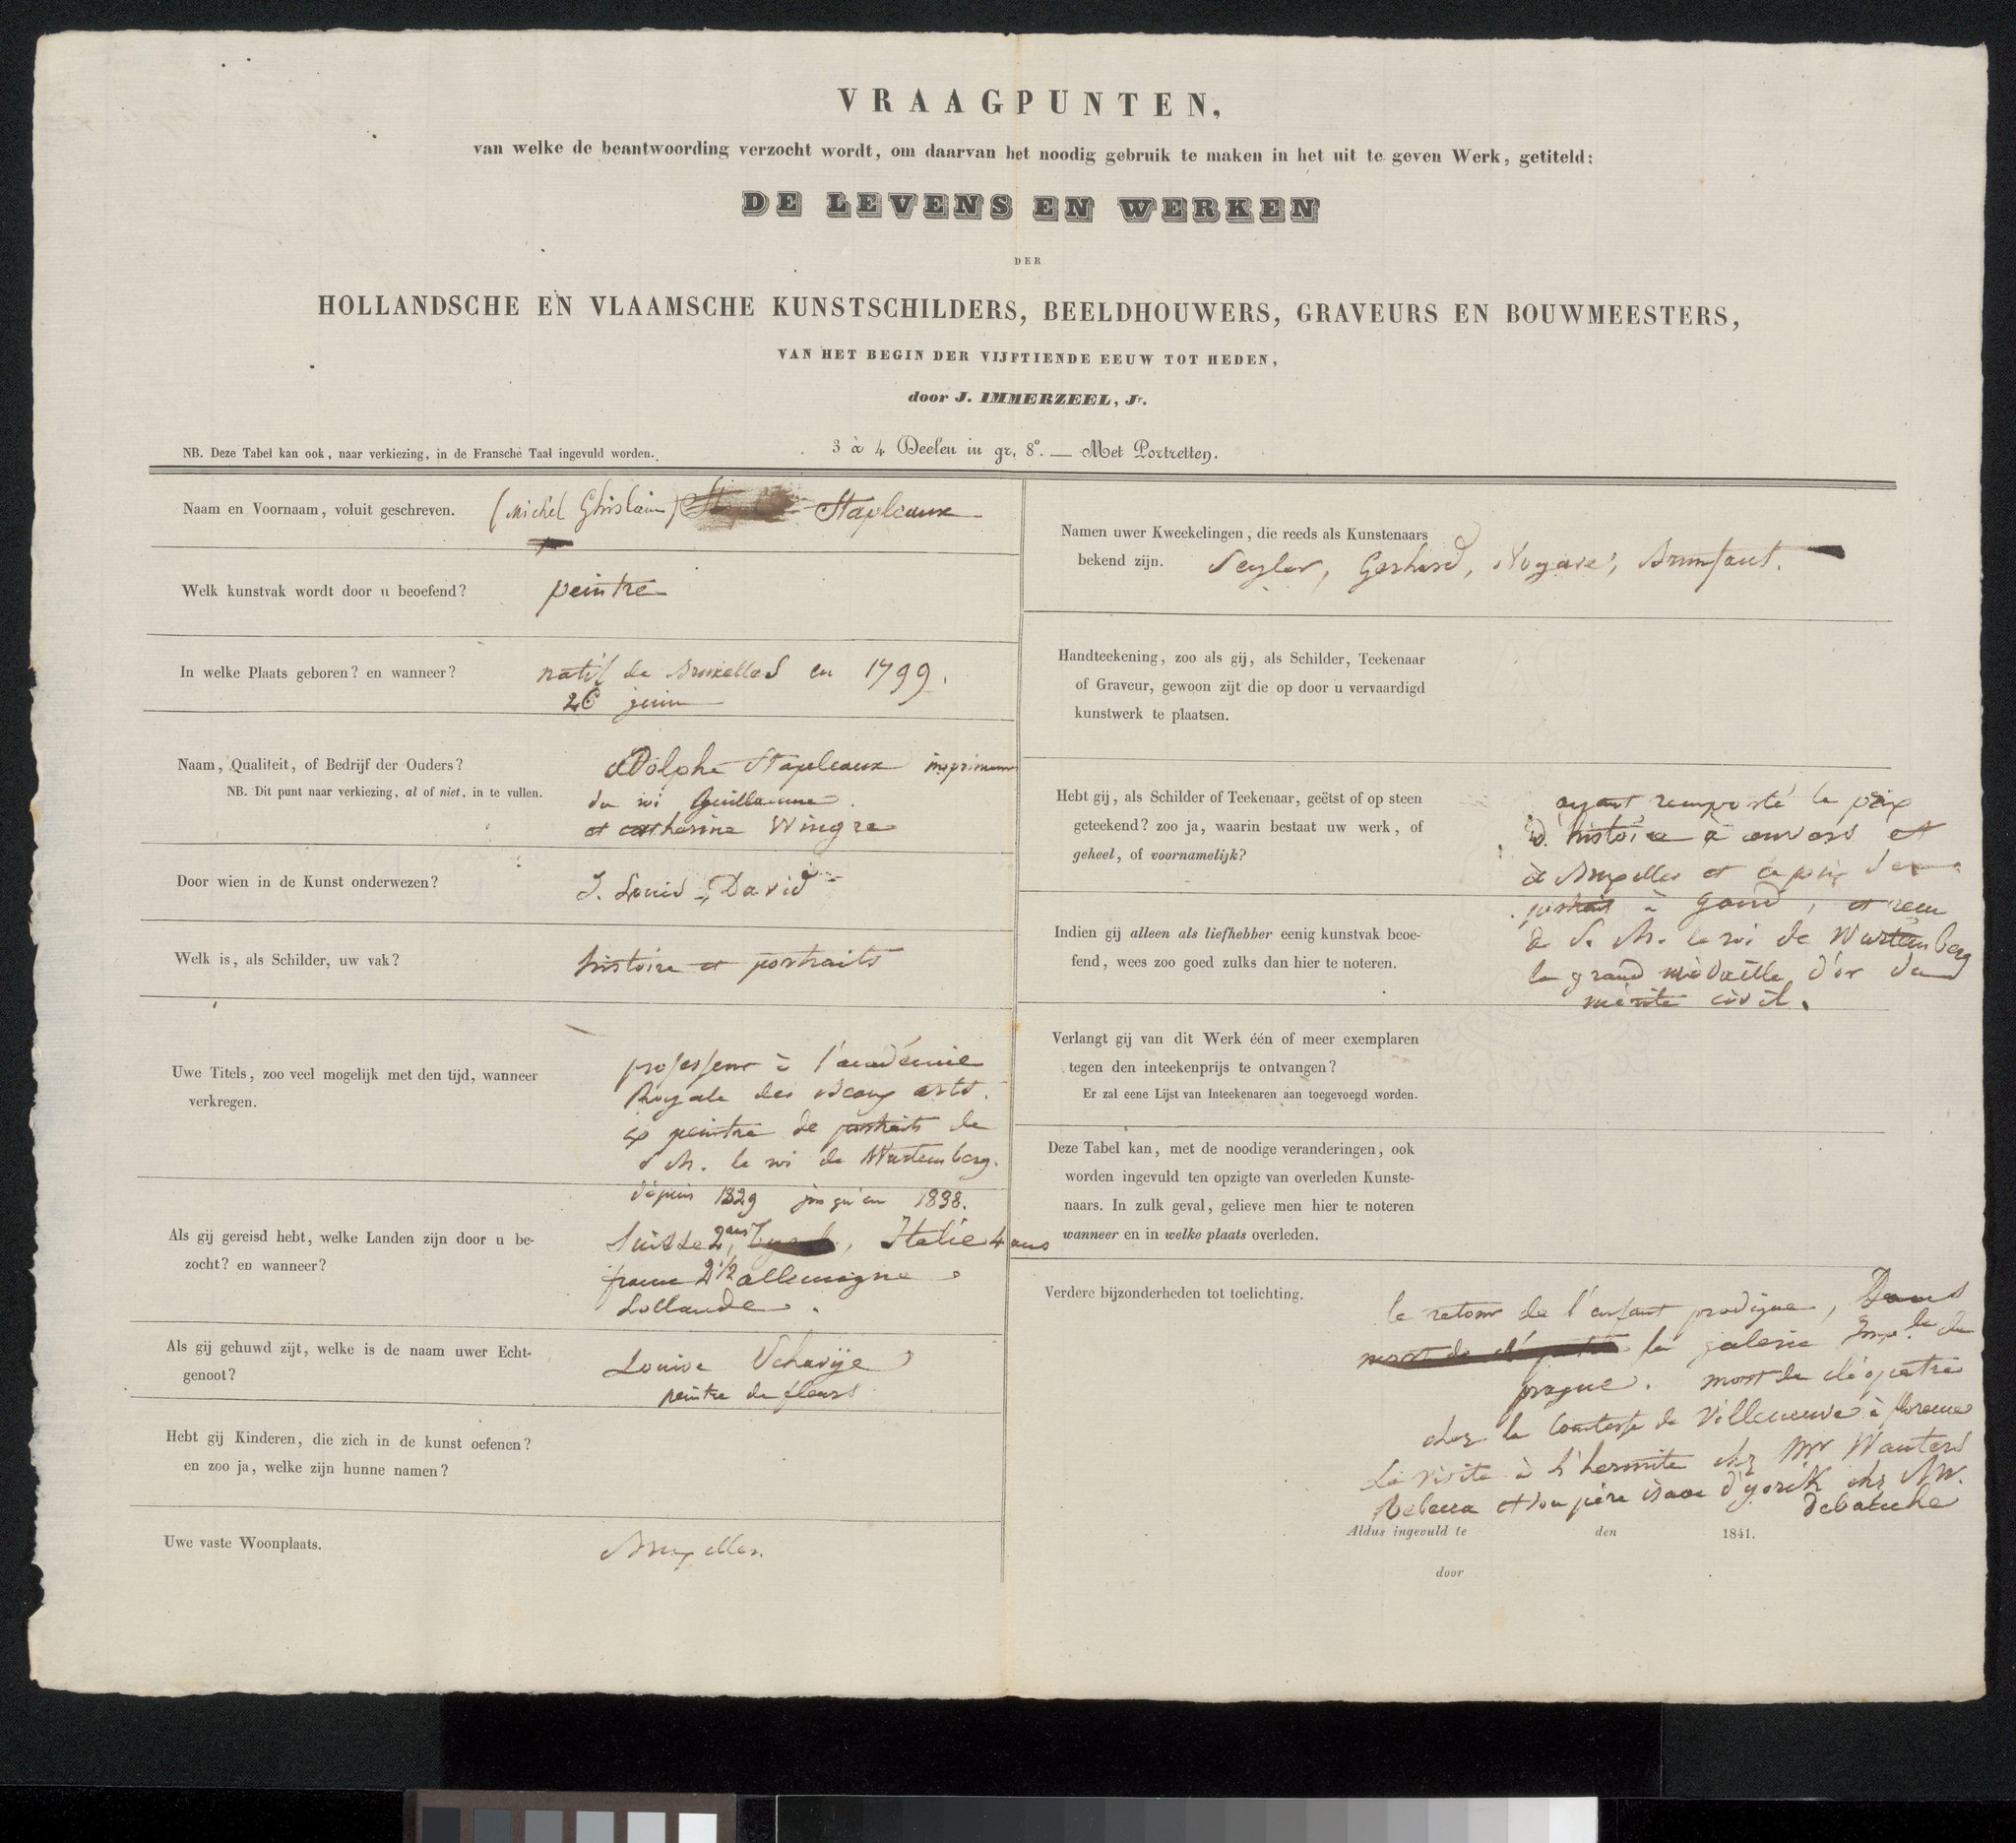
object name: questionnaire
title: Enquêteformulier ingevuld door Michael Ghislain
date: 1840-1841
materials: ink, paper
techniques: pen, printing, writing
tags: painter, michel ghislain stapleaux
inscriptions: watermark, inscription: ‘Vraagpunten,/ van welke de beantwoording verzocht wordt, om daarvan het noodig gebruik te maken in het uit te geven Werk, getiteld: De levens en werken/ der Hollandsche en Vlaamsche kunstschilders, beeldhouwers,/ graveurs en bouwmeesters, van het begin der vijftiende eeuw tot heden/ door J. Immerzeel, Jr.’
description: Opgenomen in: Immerzeel, J. Jr., De levens en werken der Hollandsche en Vlaamsche kunstschilders, beeldhouwers, graveurs en bouwmeesters, van het begin der vijftiende eeuw tot heden, Amsterdam: J.C. van Kesteren, 1842-1843.